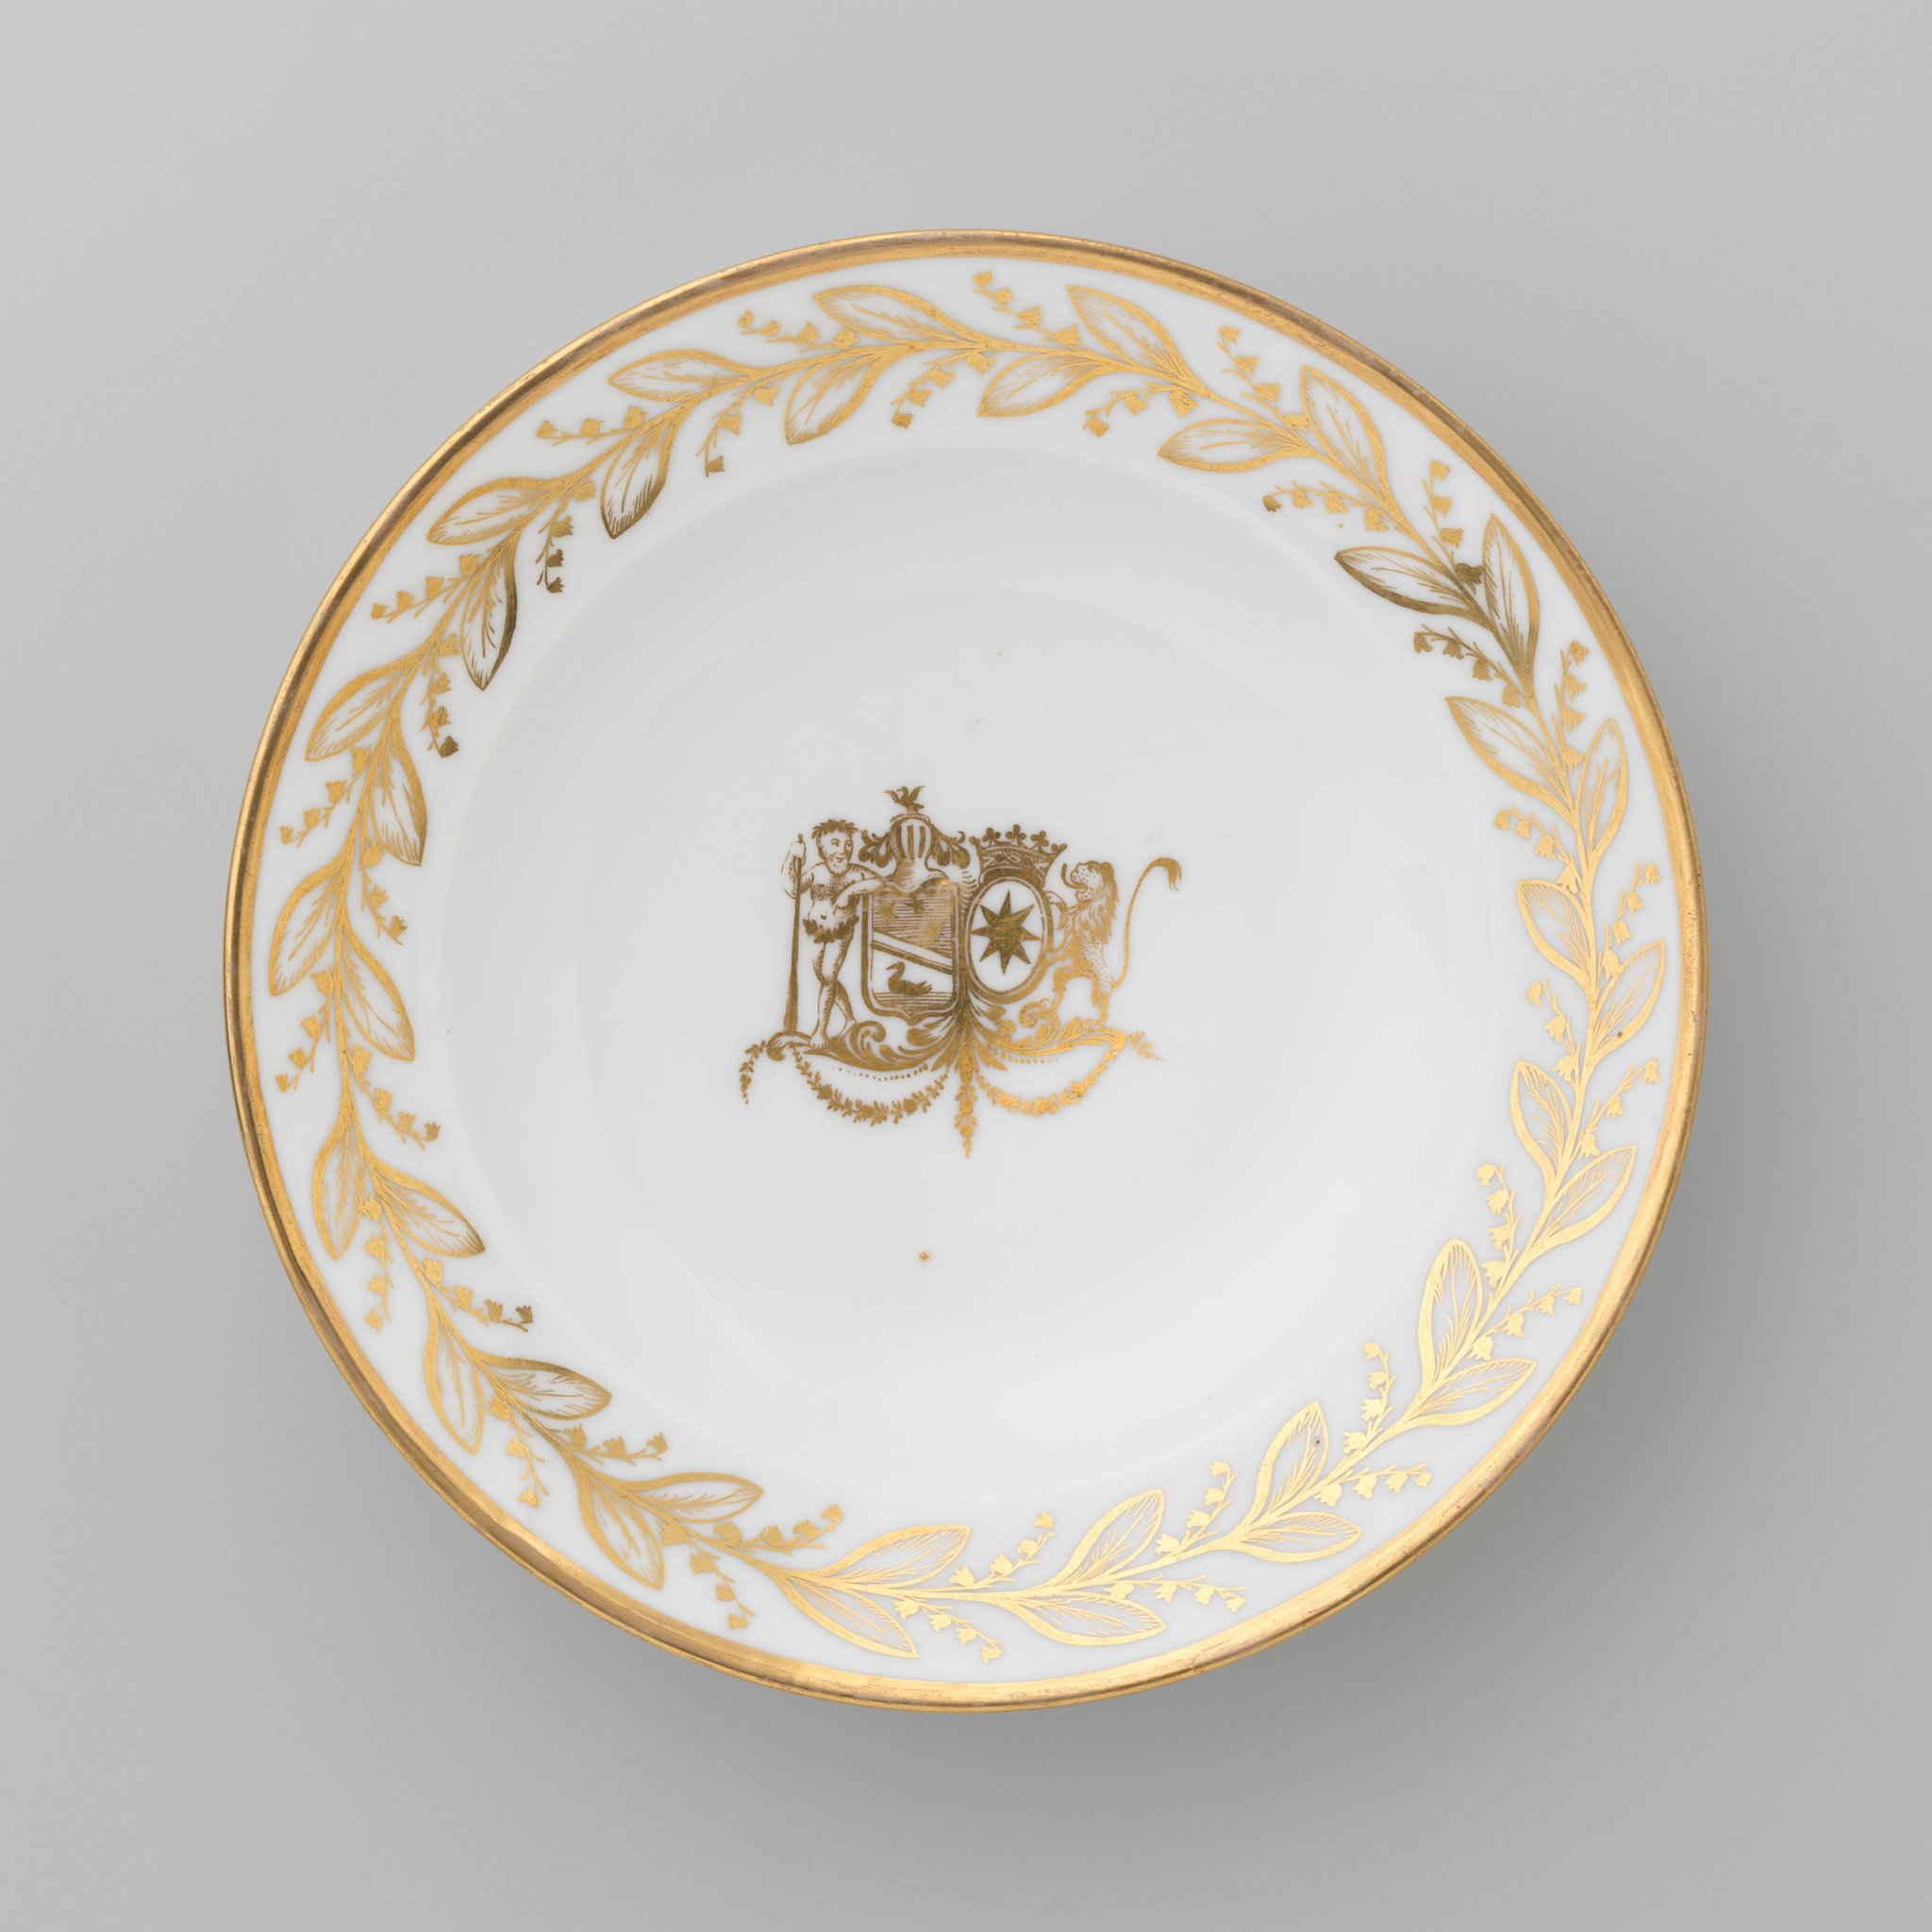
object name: service set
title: Plate with the coat of arms of Hendrik Peter Godfried Quack and Isabella Gertraud von Carnap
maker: Anonymous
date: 1790-1800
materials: glaze, gold, paint, porcelain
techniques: firing, forming, gilding, turning, vitrification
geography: paris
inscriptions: mark: ‘N’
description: Diep bord van porselein, beschilderd op het glazuur met goud. Op het plat het alliantiewapen van Hendrik Peter Godfried Quack en Isabella Gertraud von Carnap. De rand met een bloemrank en een gouden band. Een proen op de onderzijde. Gemerkt op de onderzijde met N.